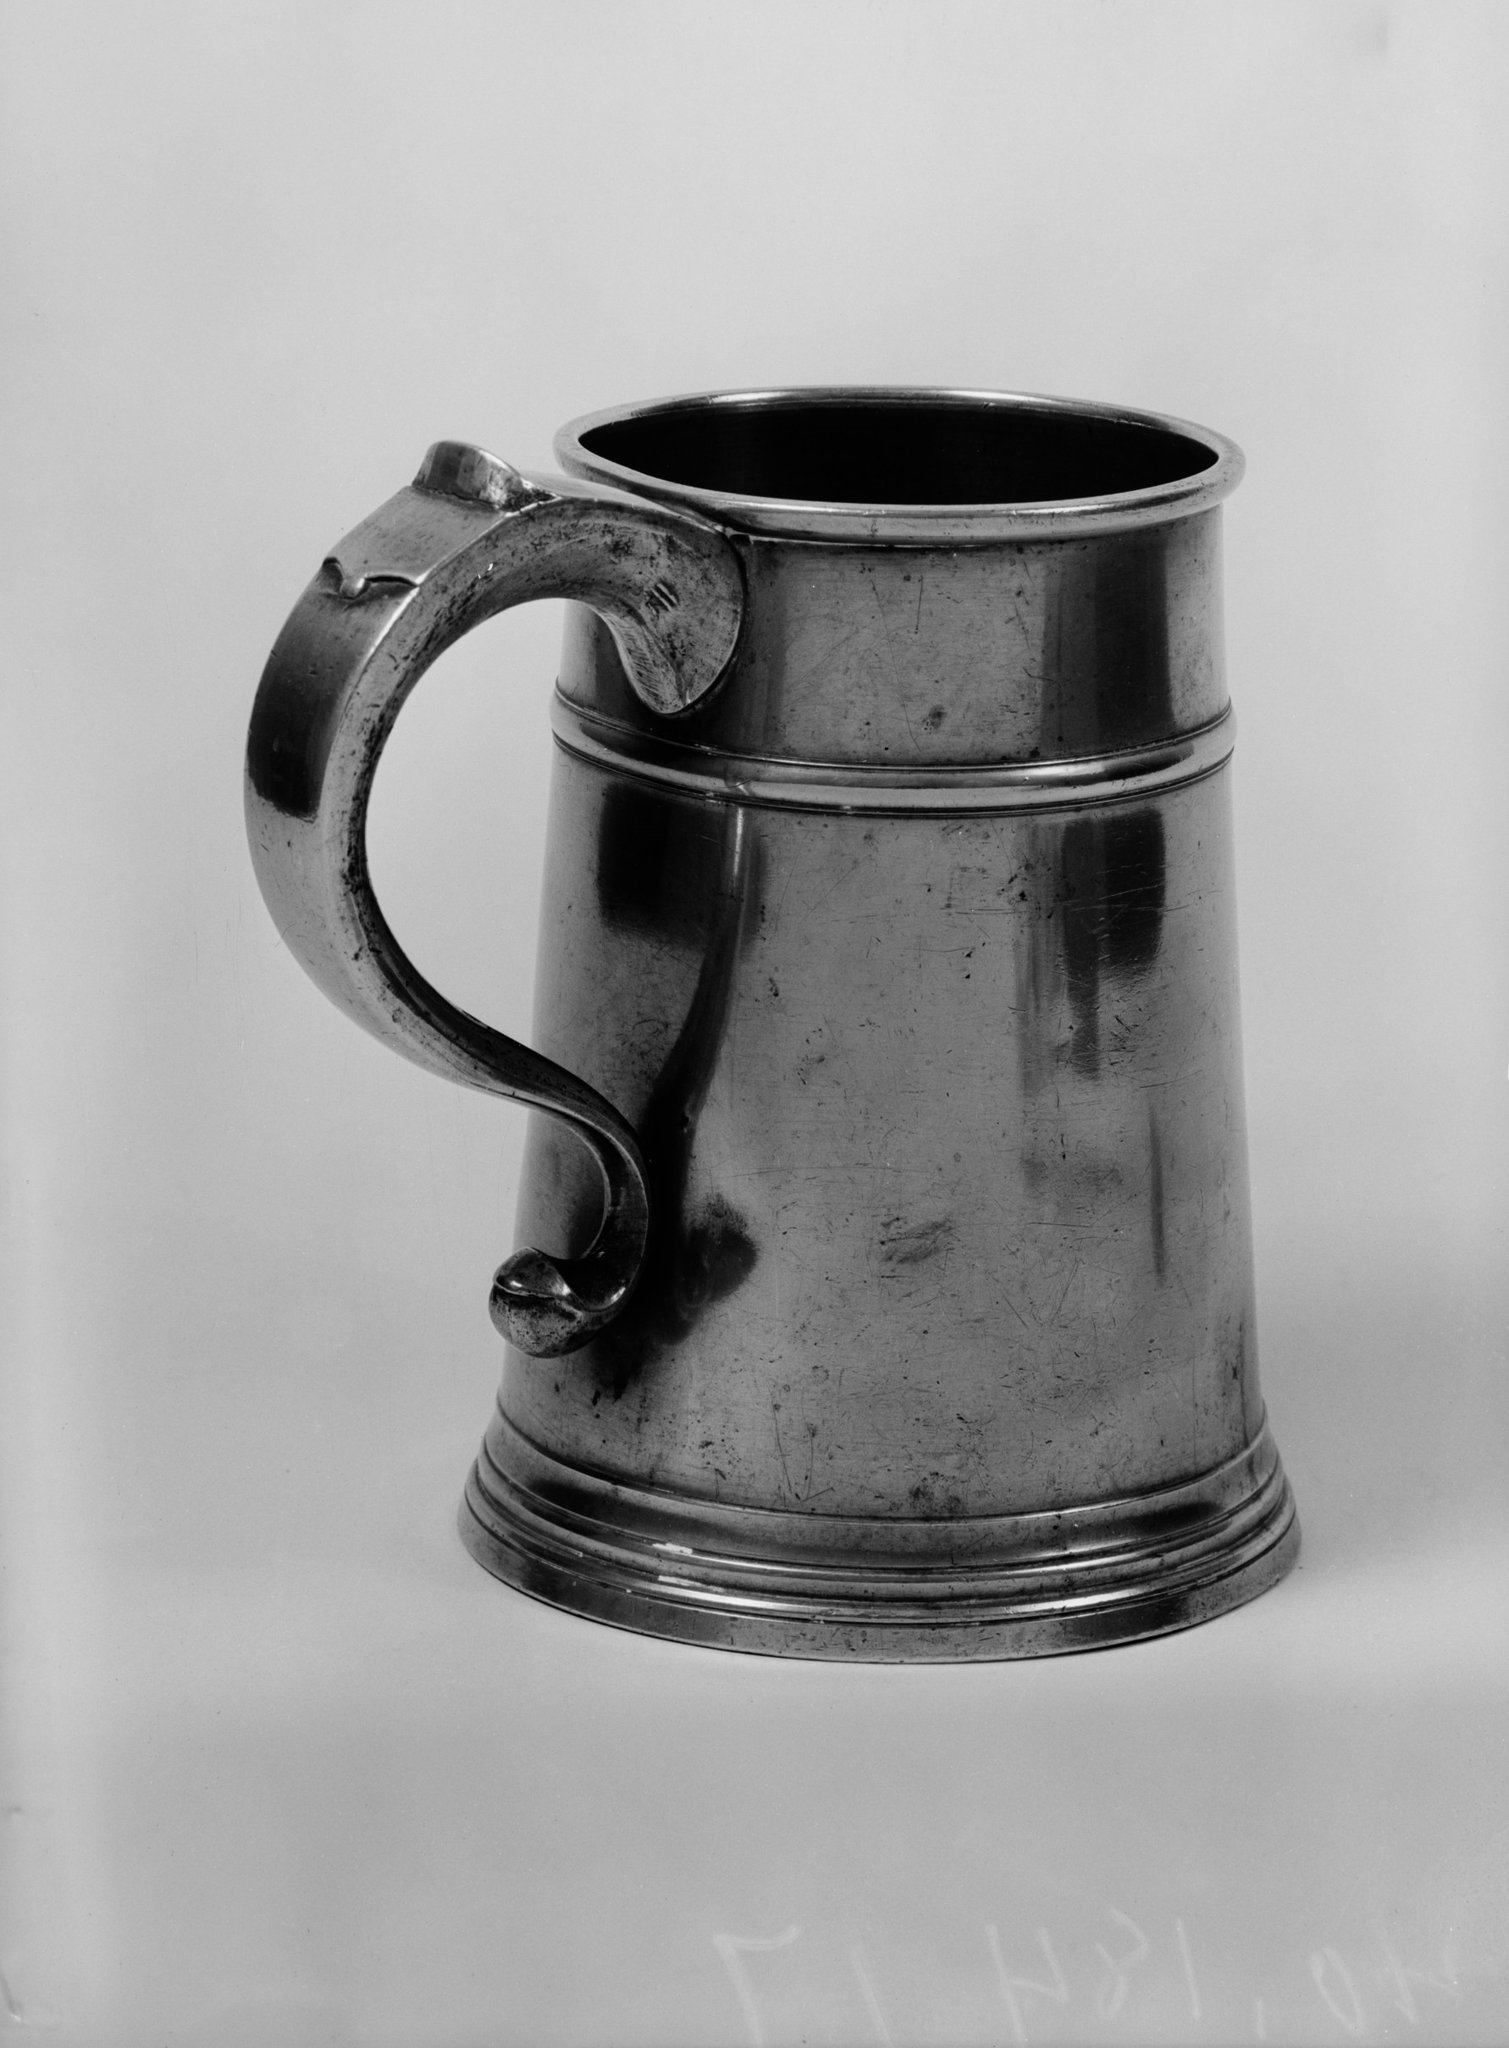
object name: mug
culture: american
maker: henry will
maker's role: maker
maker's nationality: american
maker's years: 1734-1802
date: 1761-1793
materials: pewter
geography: united states